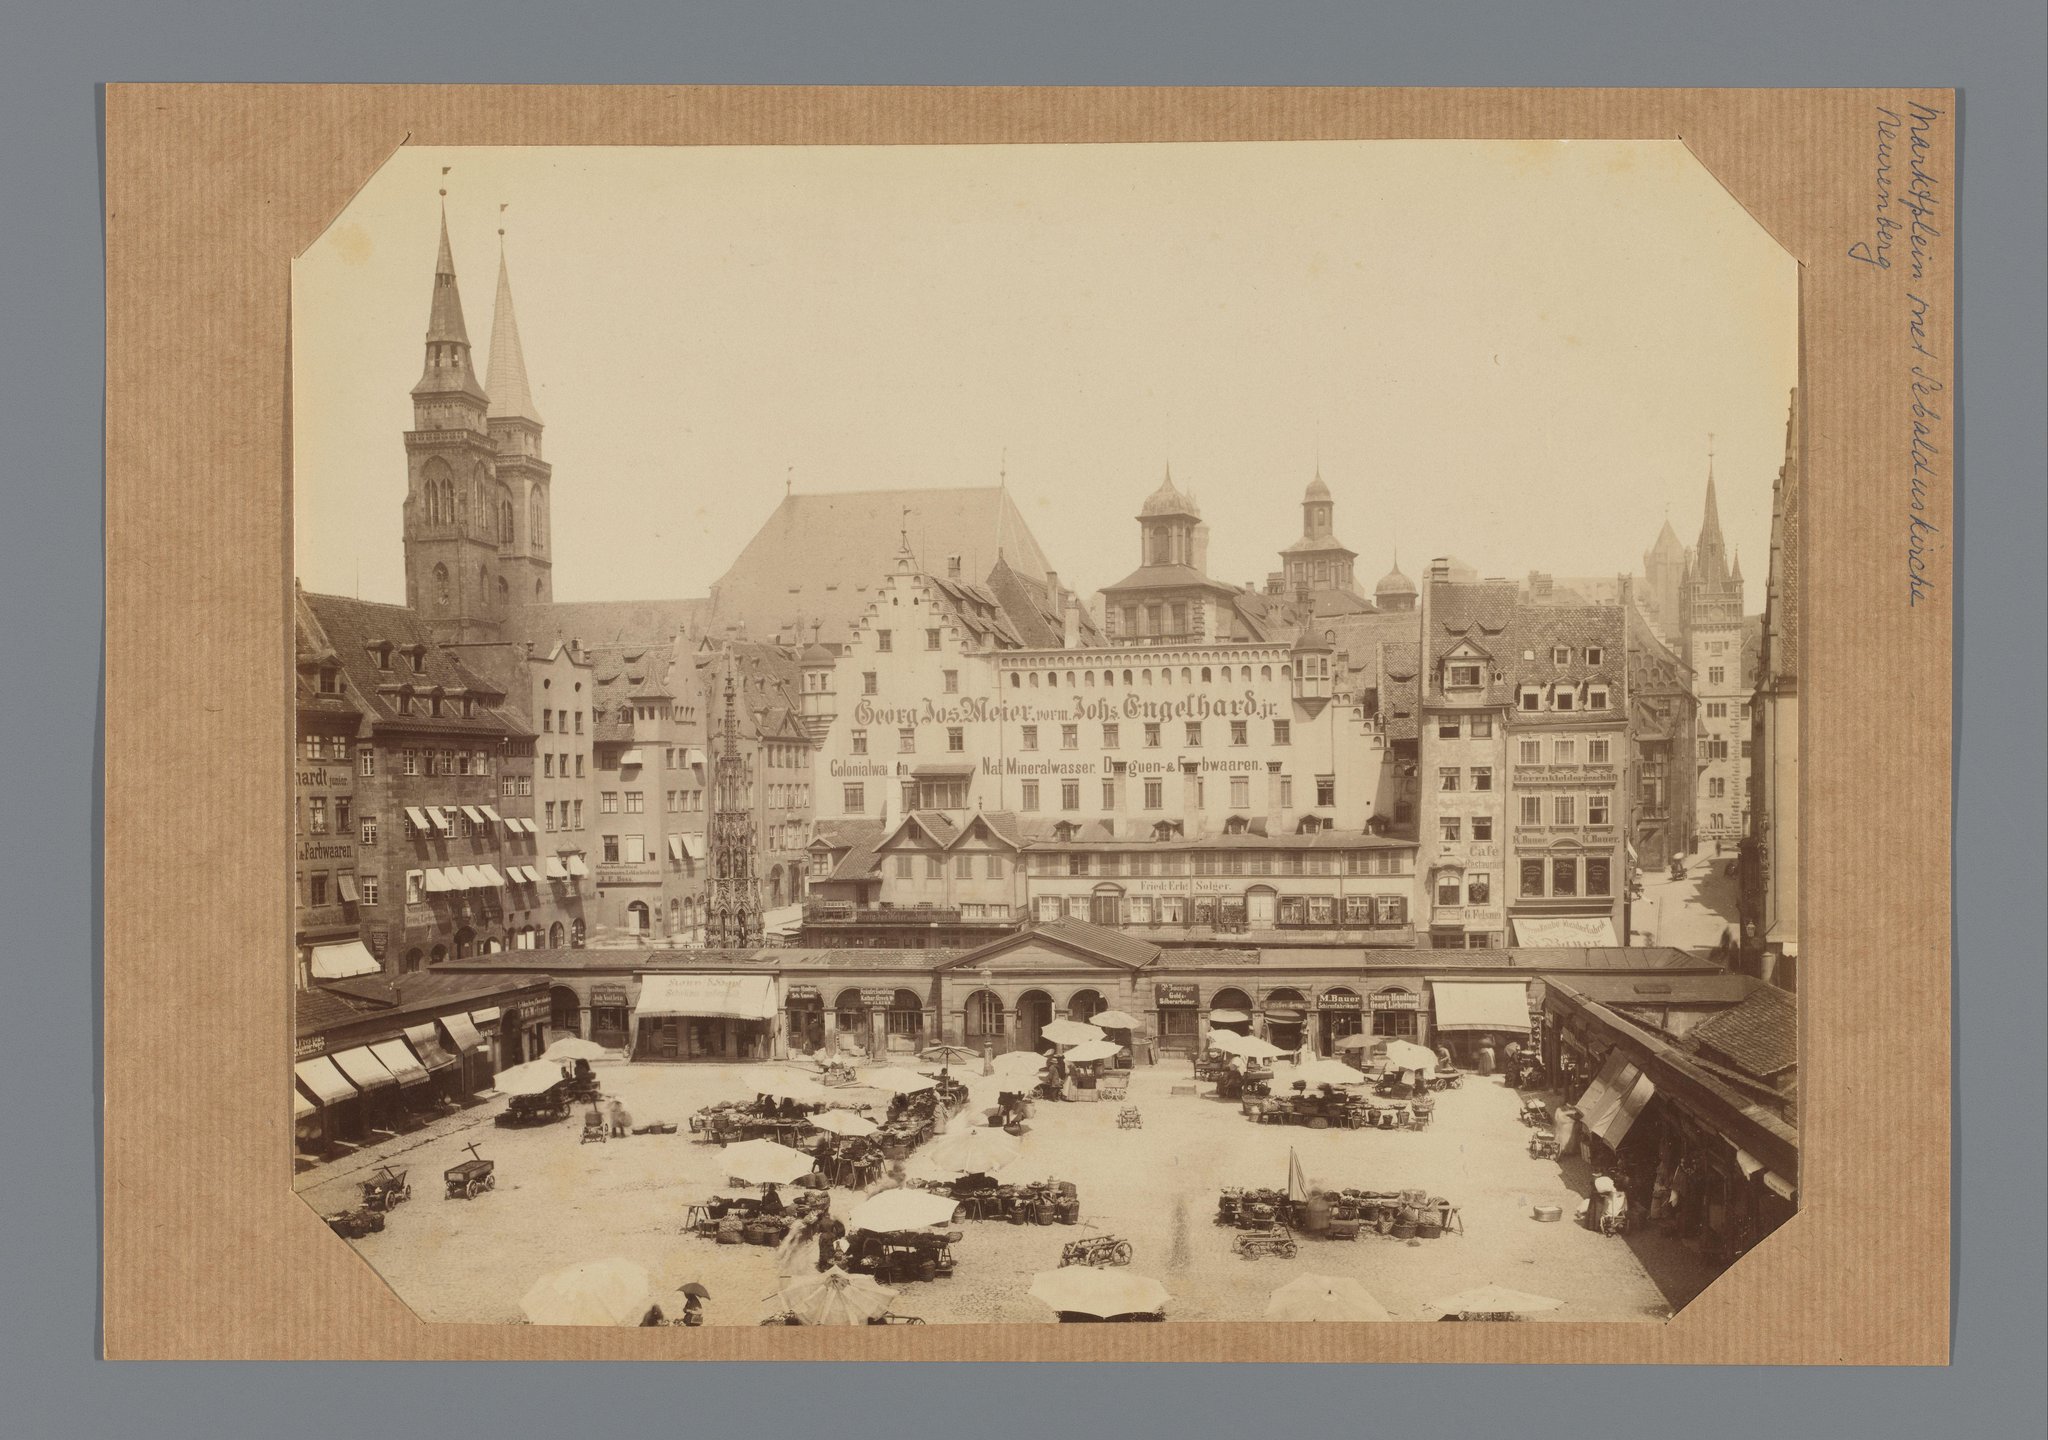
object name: photograph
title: Neurenberg, Marktplein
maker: Anonymous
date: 1850-1890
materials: photographic support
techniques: albumen print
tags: neurenberg